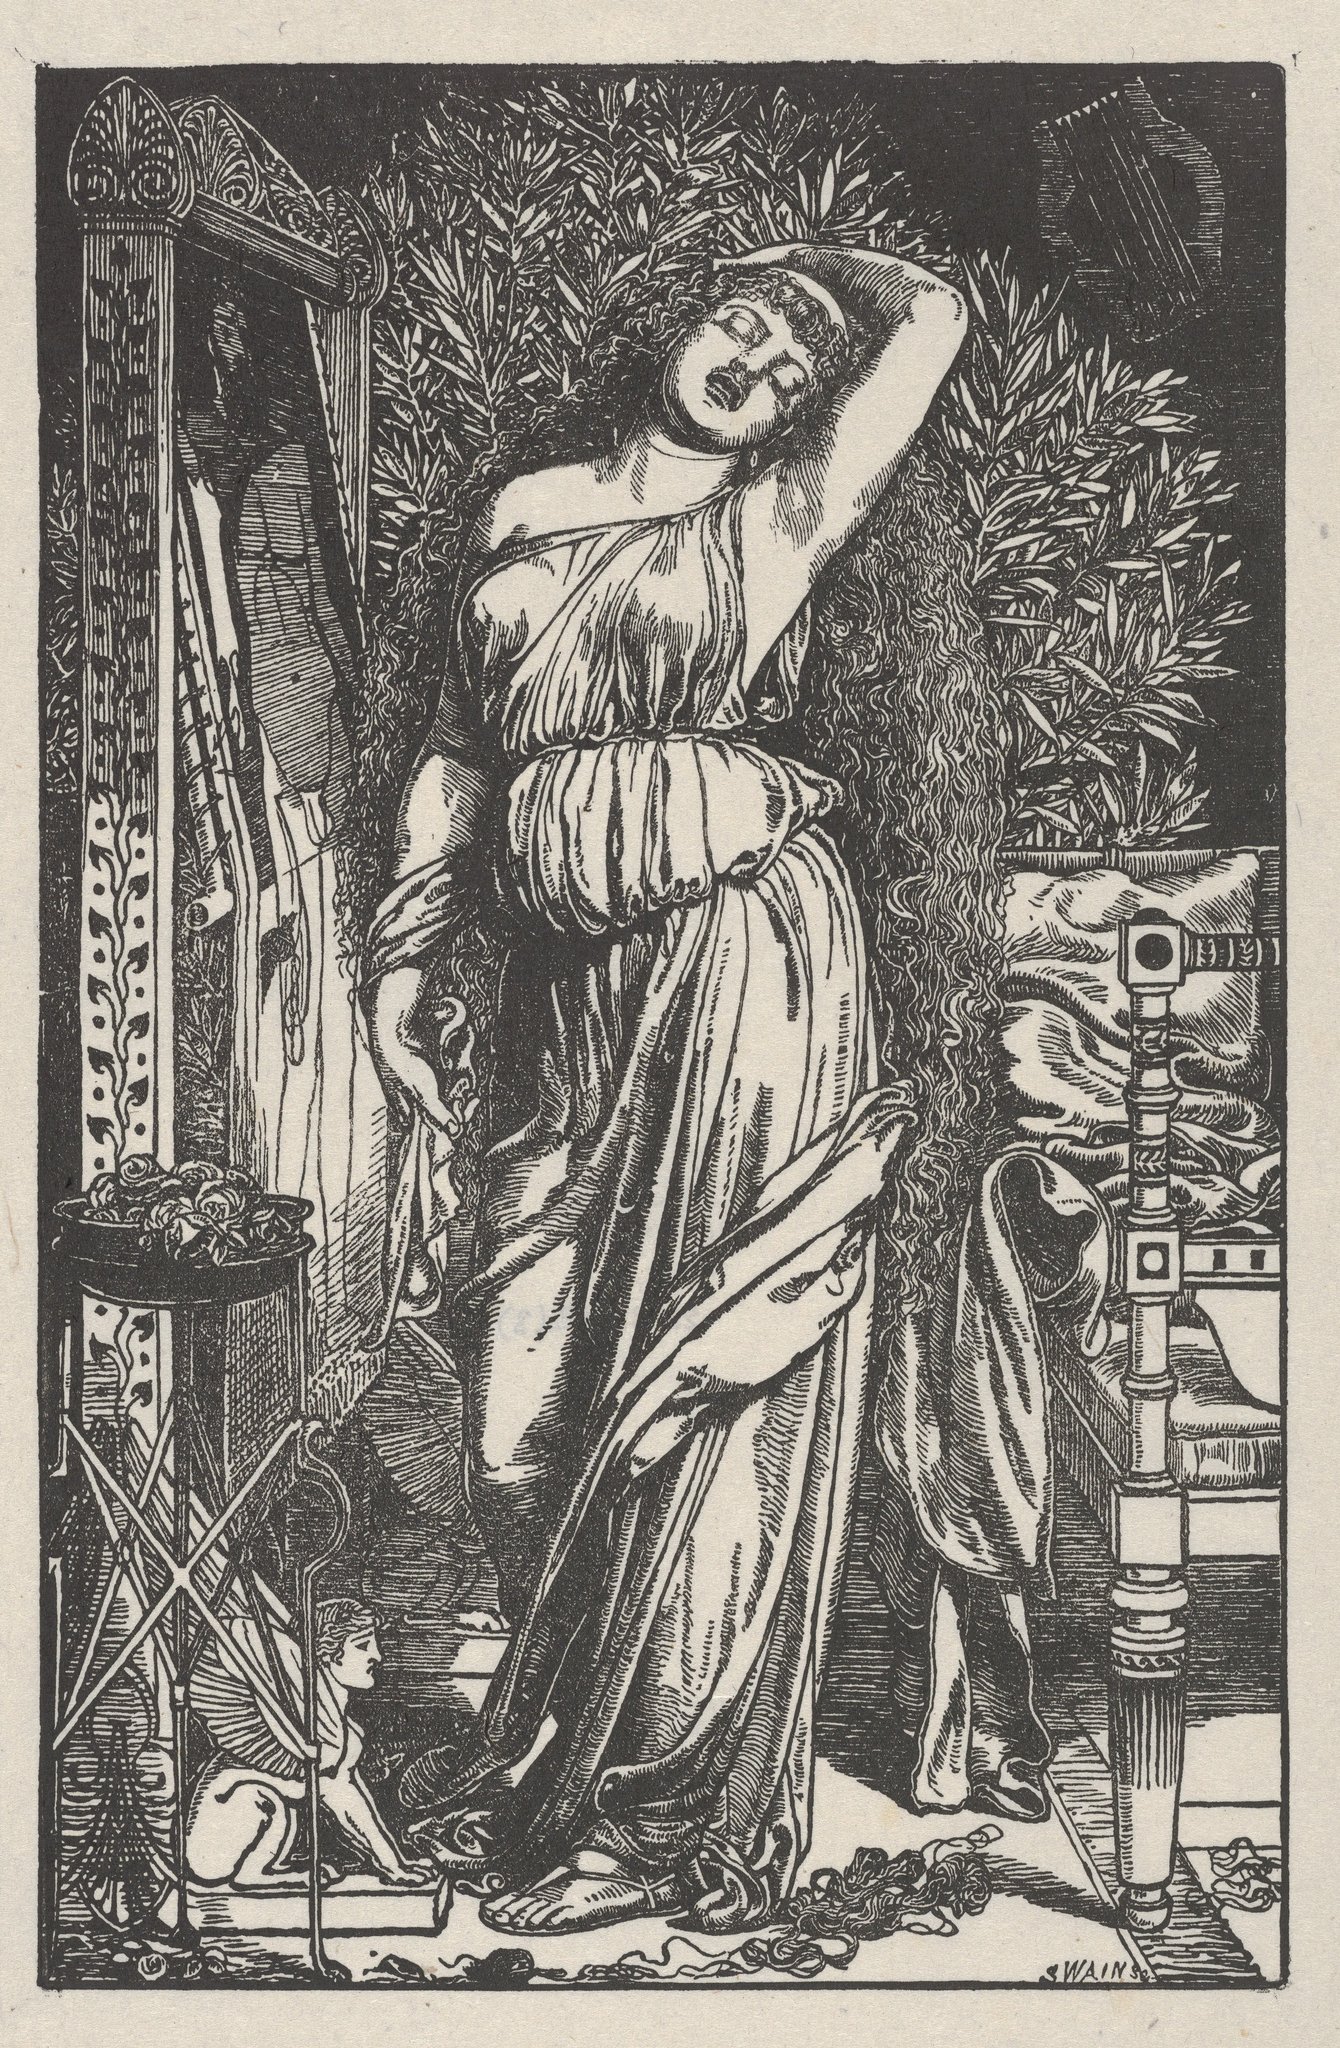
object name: print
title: Danaë in the Brazen Chamber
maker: frederick augustus sandys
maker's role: artist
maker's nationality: british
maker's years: 1829-1904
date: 1867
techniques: engraving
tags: women